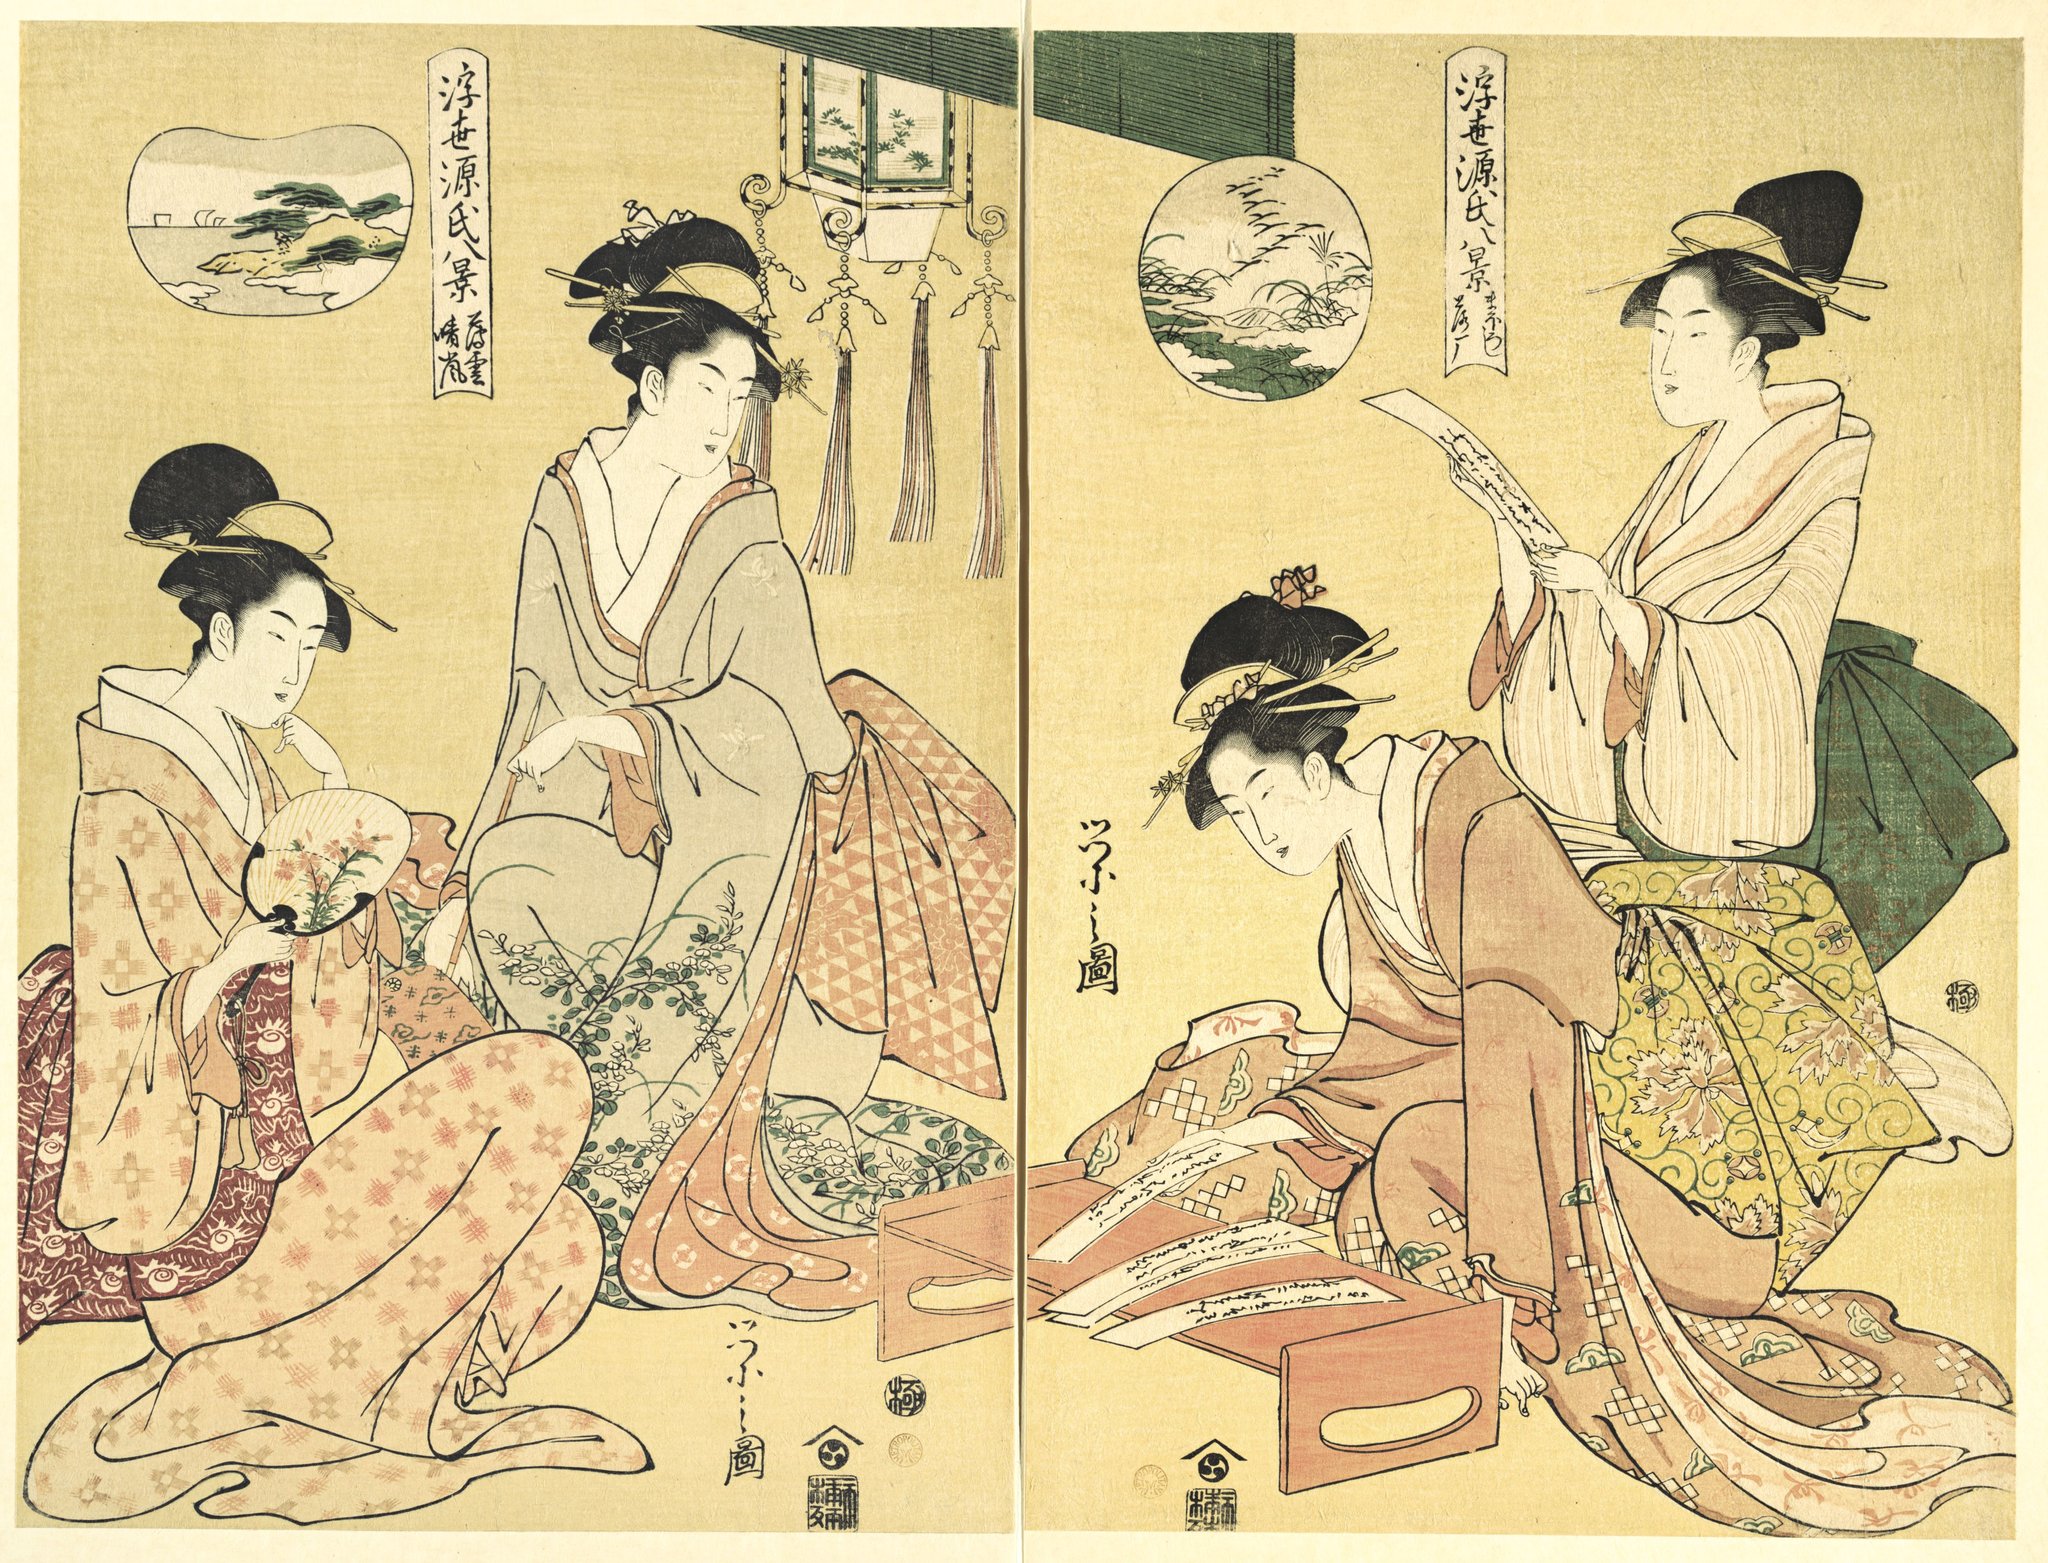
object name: print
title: Spirit Summoner; Wild Geese Returning Home (Maboroshi; Rakugan) (right) and A Thin Veil of Clouds; Clearing Weather (Usugumo; Seiran) (left), from the series Eight Views of The Tale of Genji in the Floating World (Ukiyo Genji hakkei)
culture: japanese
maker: chōbunsai eishi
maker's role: artist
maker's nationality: japanese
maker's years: 1756-1829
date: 1797-1799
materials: ink, paper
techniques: woodblock print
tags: women